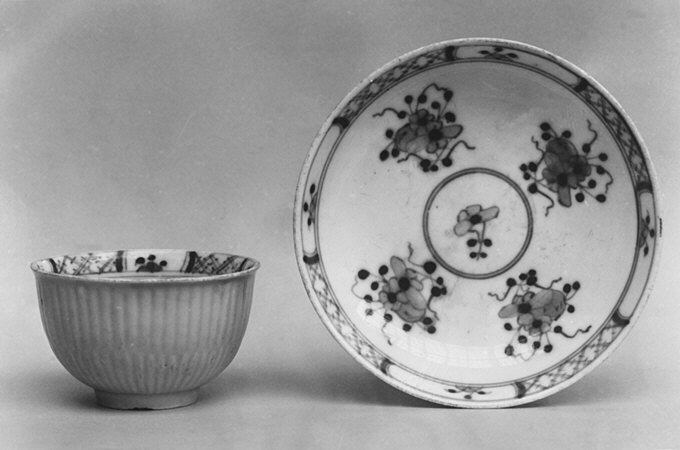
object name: cup and saucer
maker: meissen manufactory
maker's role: manufactory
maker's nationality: german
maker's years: 1710-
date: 1750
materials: hard paste porcelain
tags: flowers